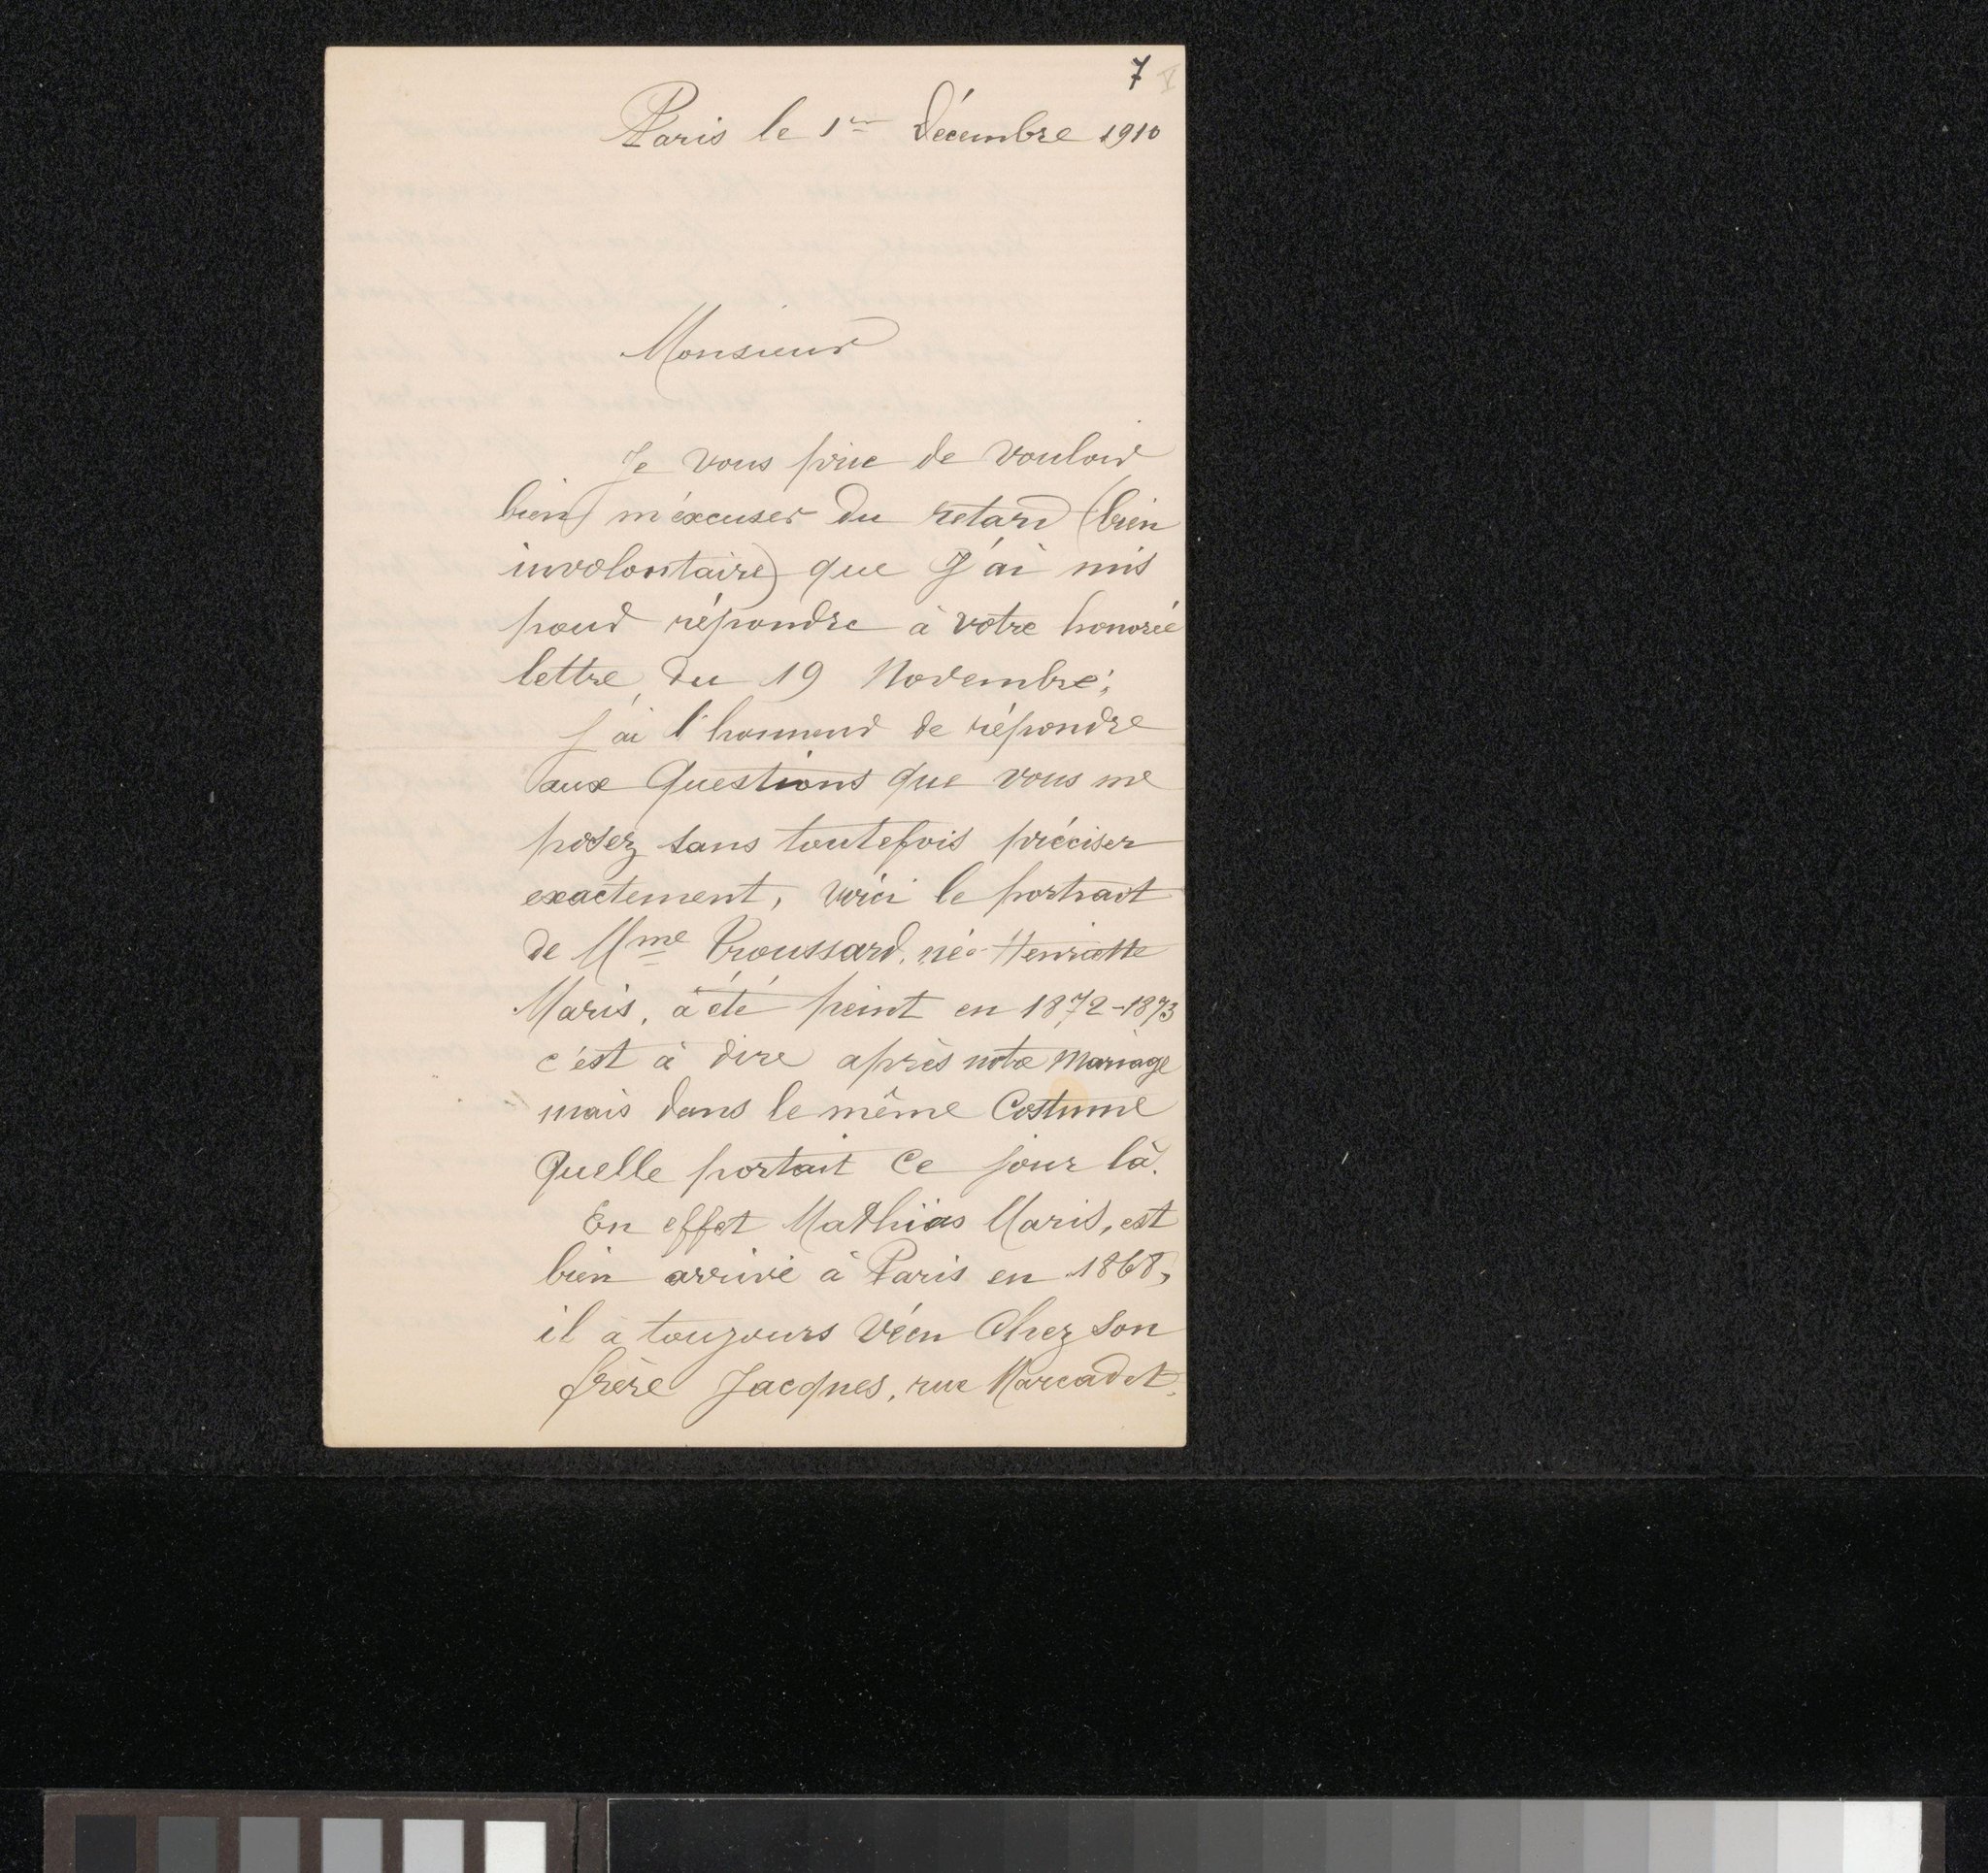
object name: letter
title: Brief aan Pieter Haverkorn van Rijsewijk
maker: Anonymous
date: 1910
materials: ink, paper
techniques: pen, writing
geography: paris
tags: glasgow, painter, draughtsman, daniel cottier, the hague, print maker, matthijs maris, pieter haverkorn van rijsewijk, painting (including book-illumination, miniature-painting), historical persons (portraits and scenes from the life), paris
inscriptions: watermark